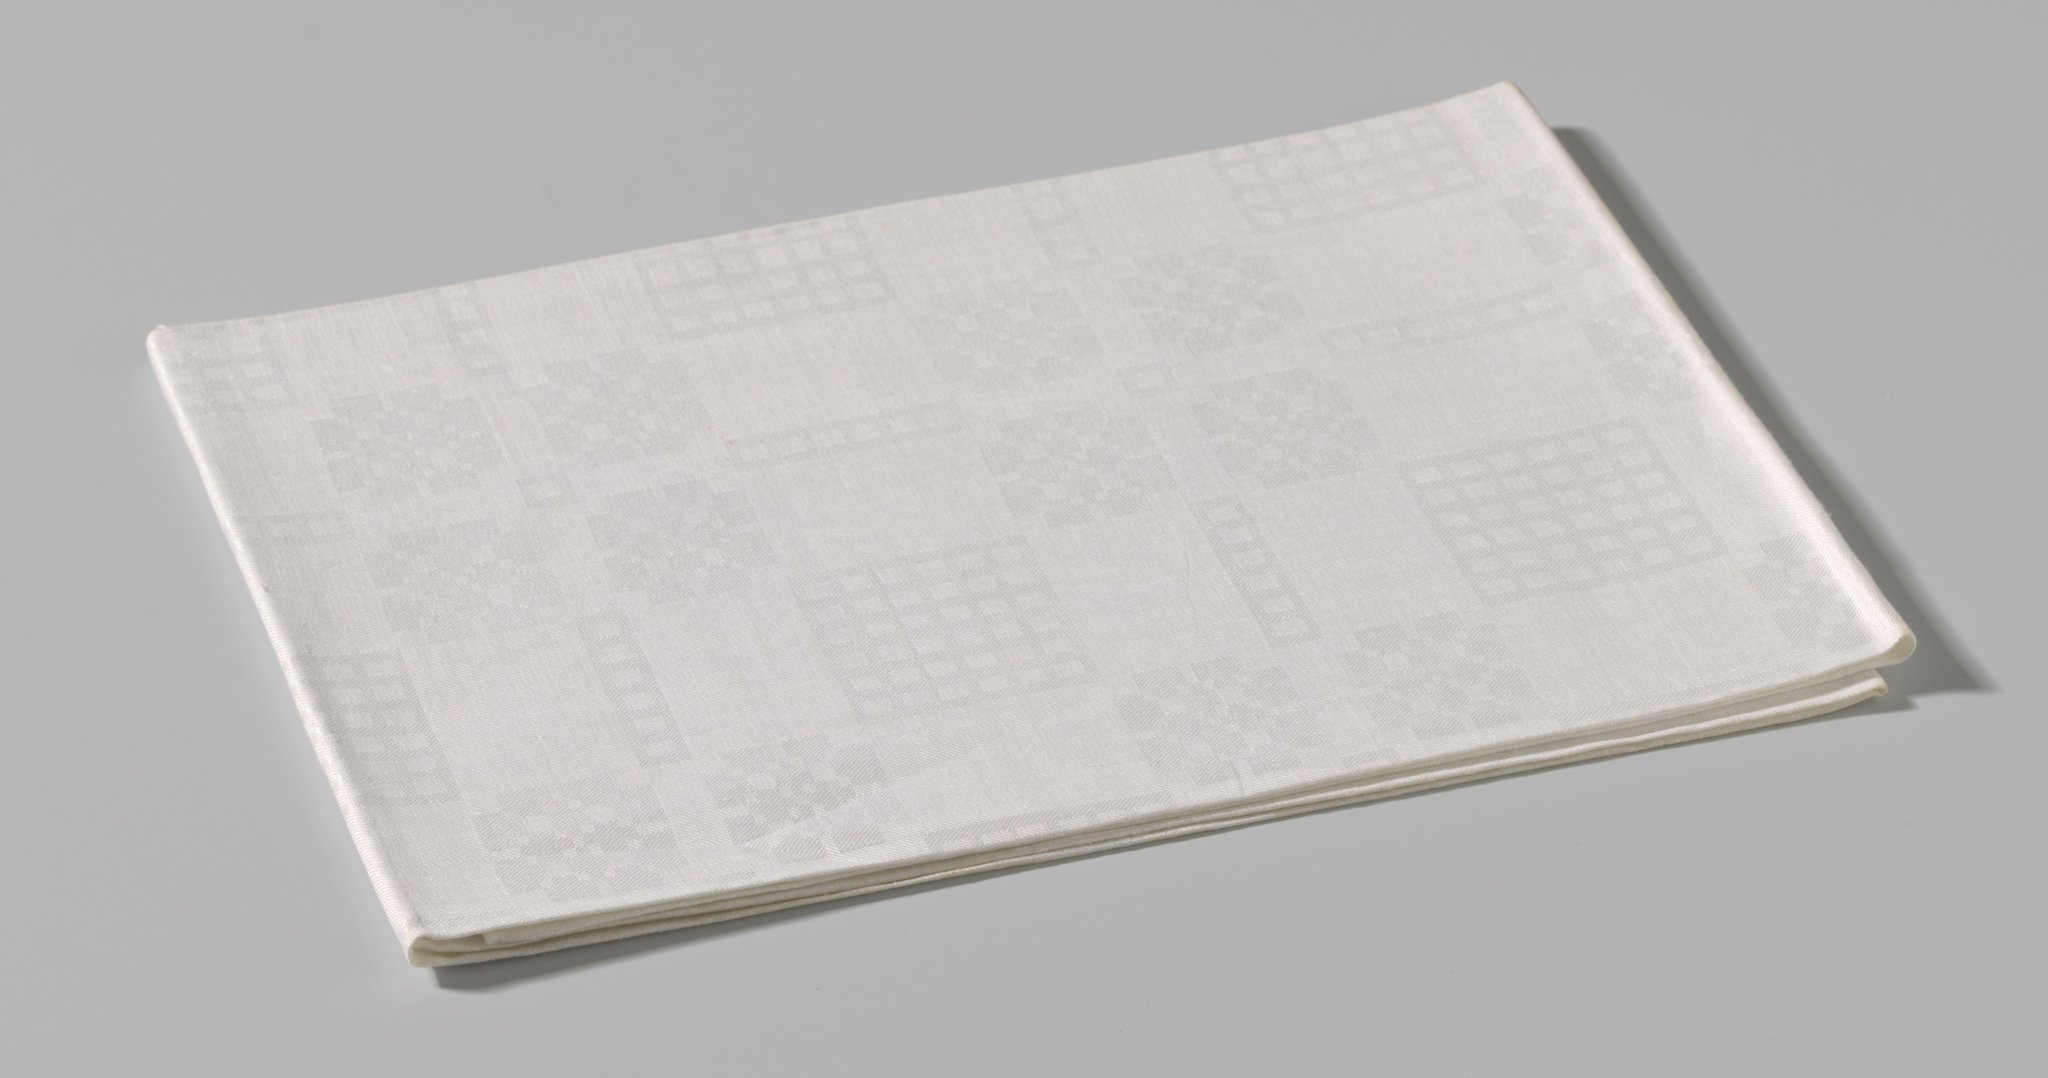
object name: napkin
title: Servet met pellenpatroon met wafelruit en bloemvorm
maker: Anonymous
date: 1675-1725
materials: linen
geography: northern netherlands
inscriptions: mark: ‘48’, mark: ‘BS’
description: Servet van wit linnen met een pellen patroon in keper, een wafelruitje met een soort bloem, merk BS en 48.